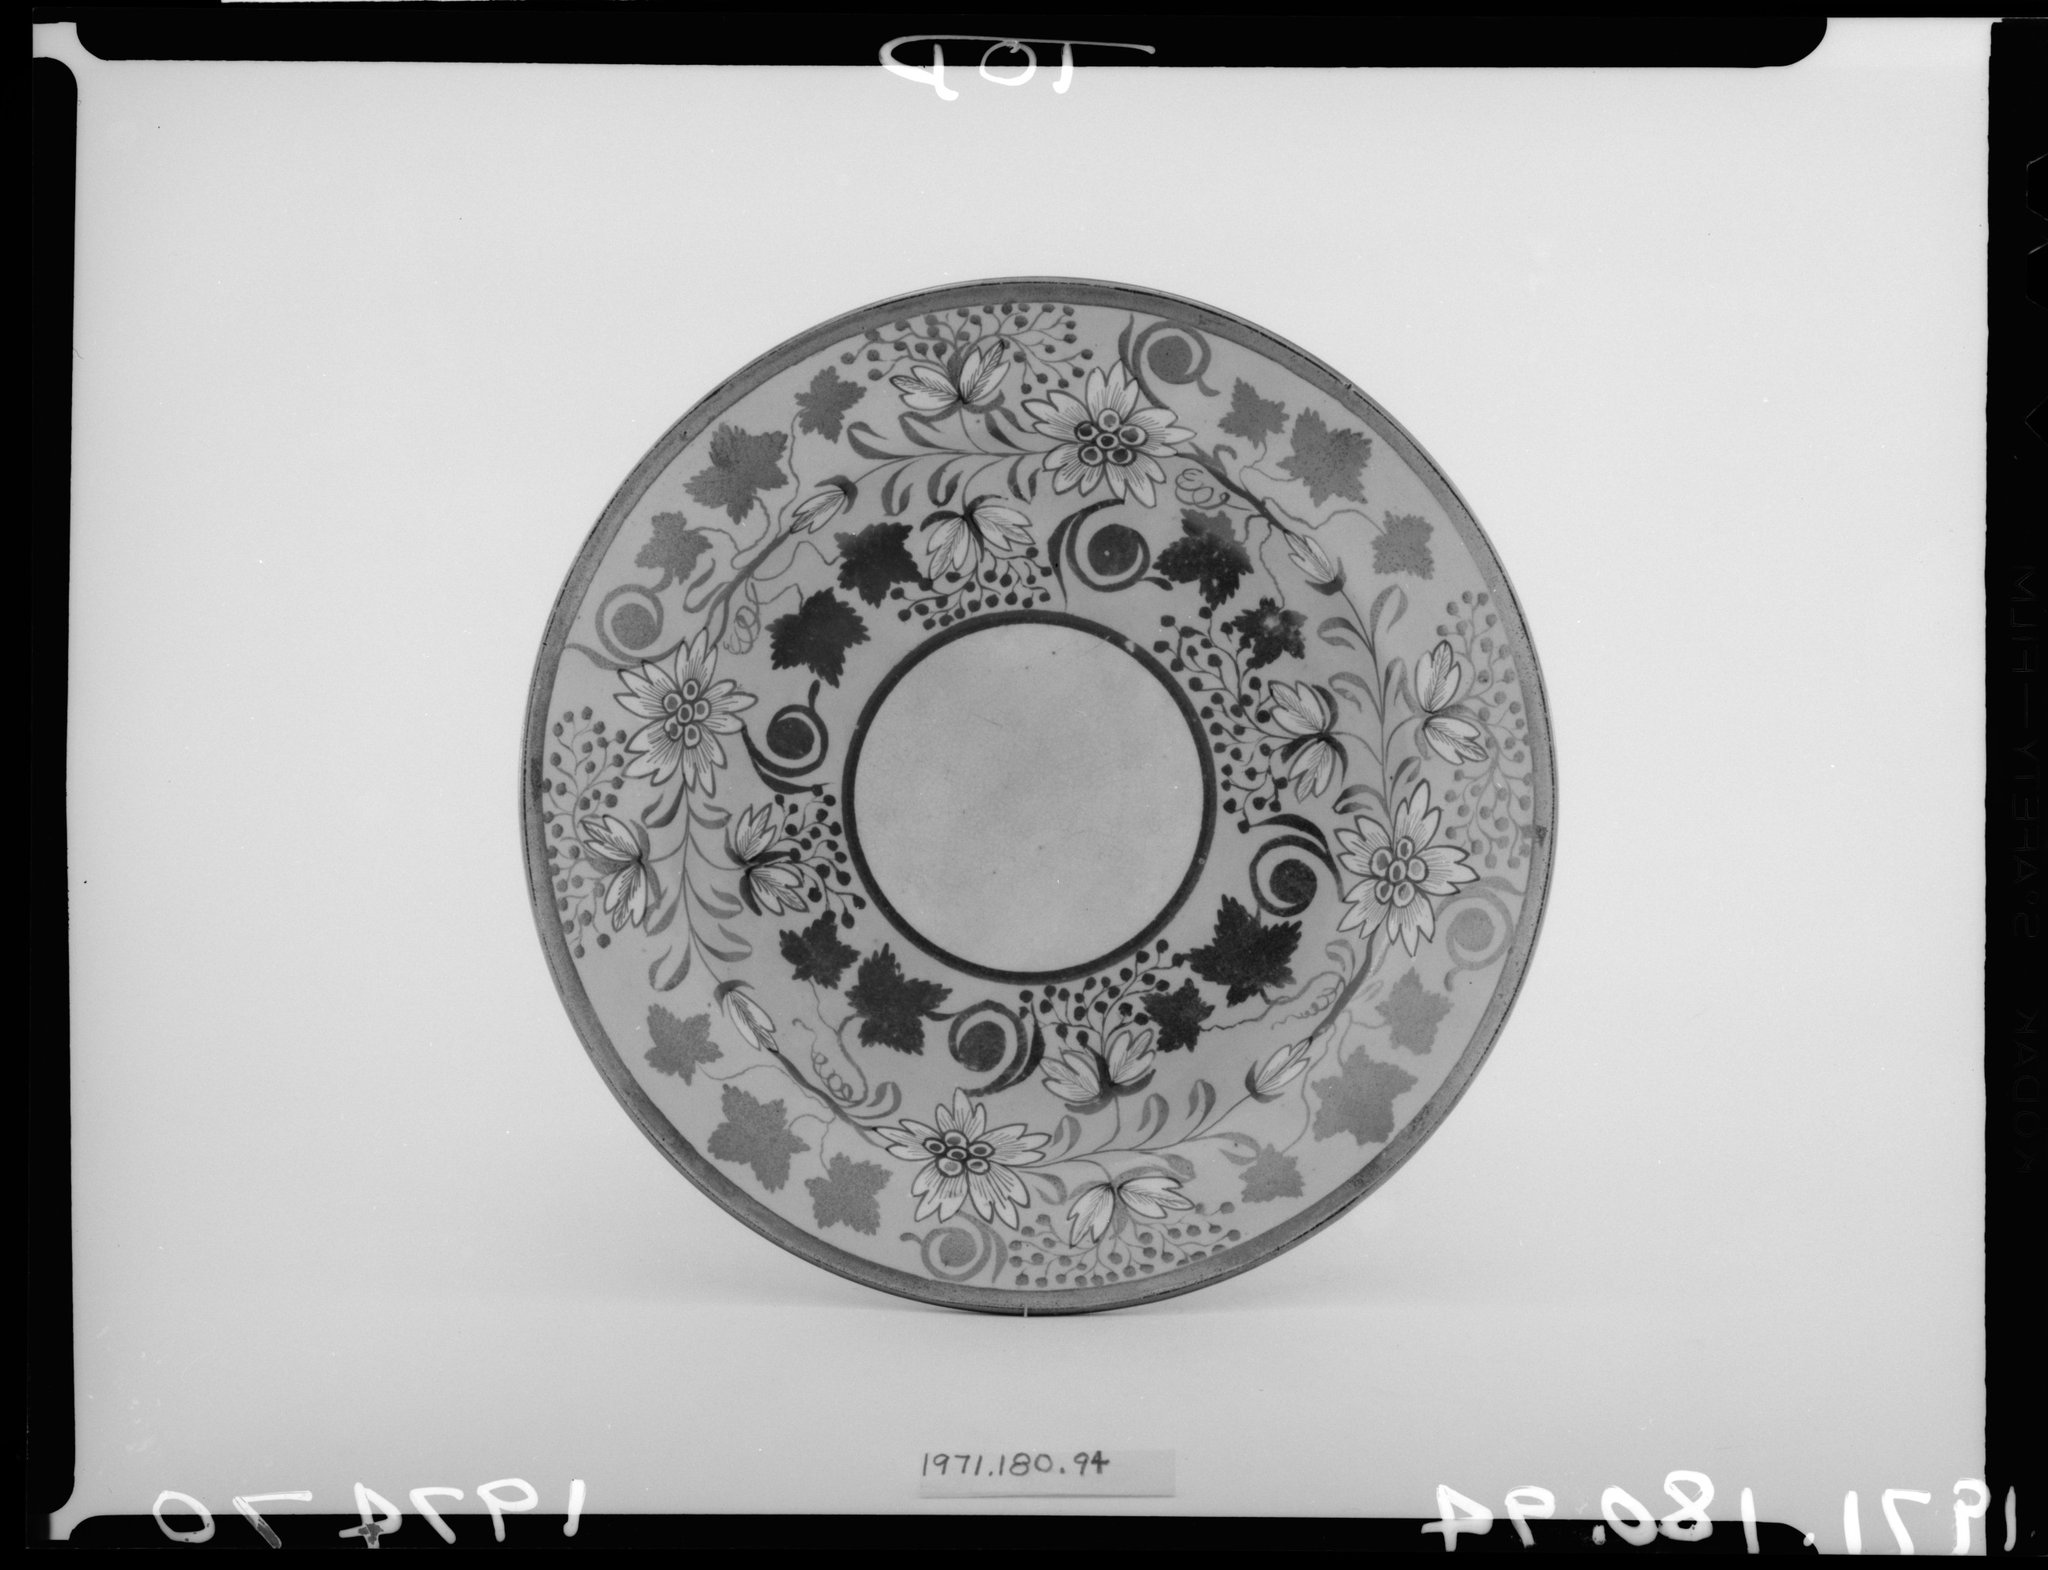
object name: plate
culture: british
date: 1835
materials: earthenware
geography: england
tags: flowers